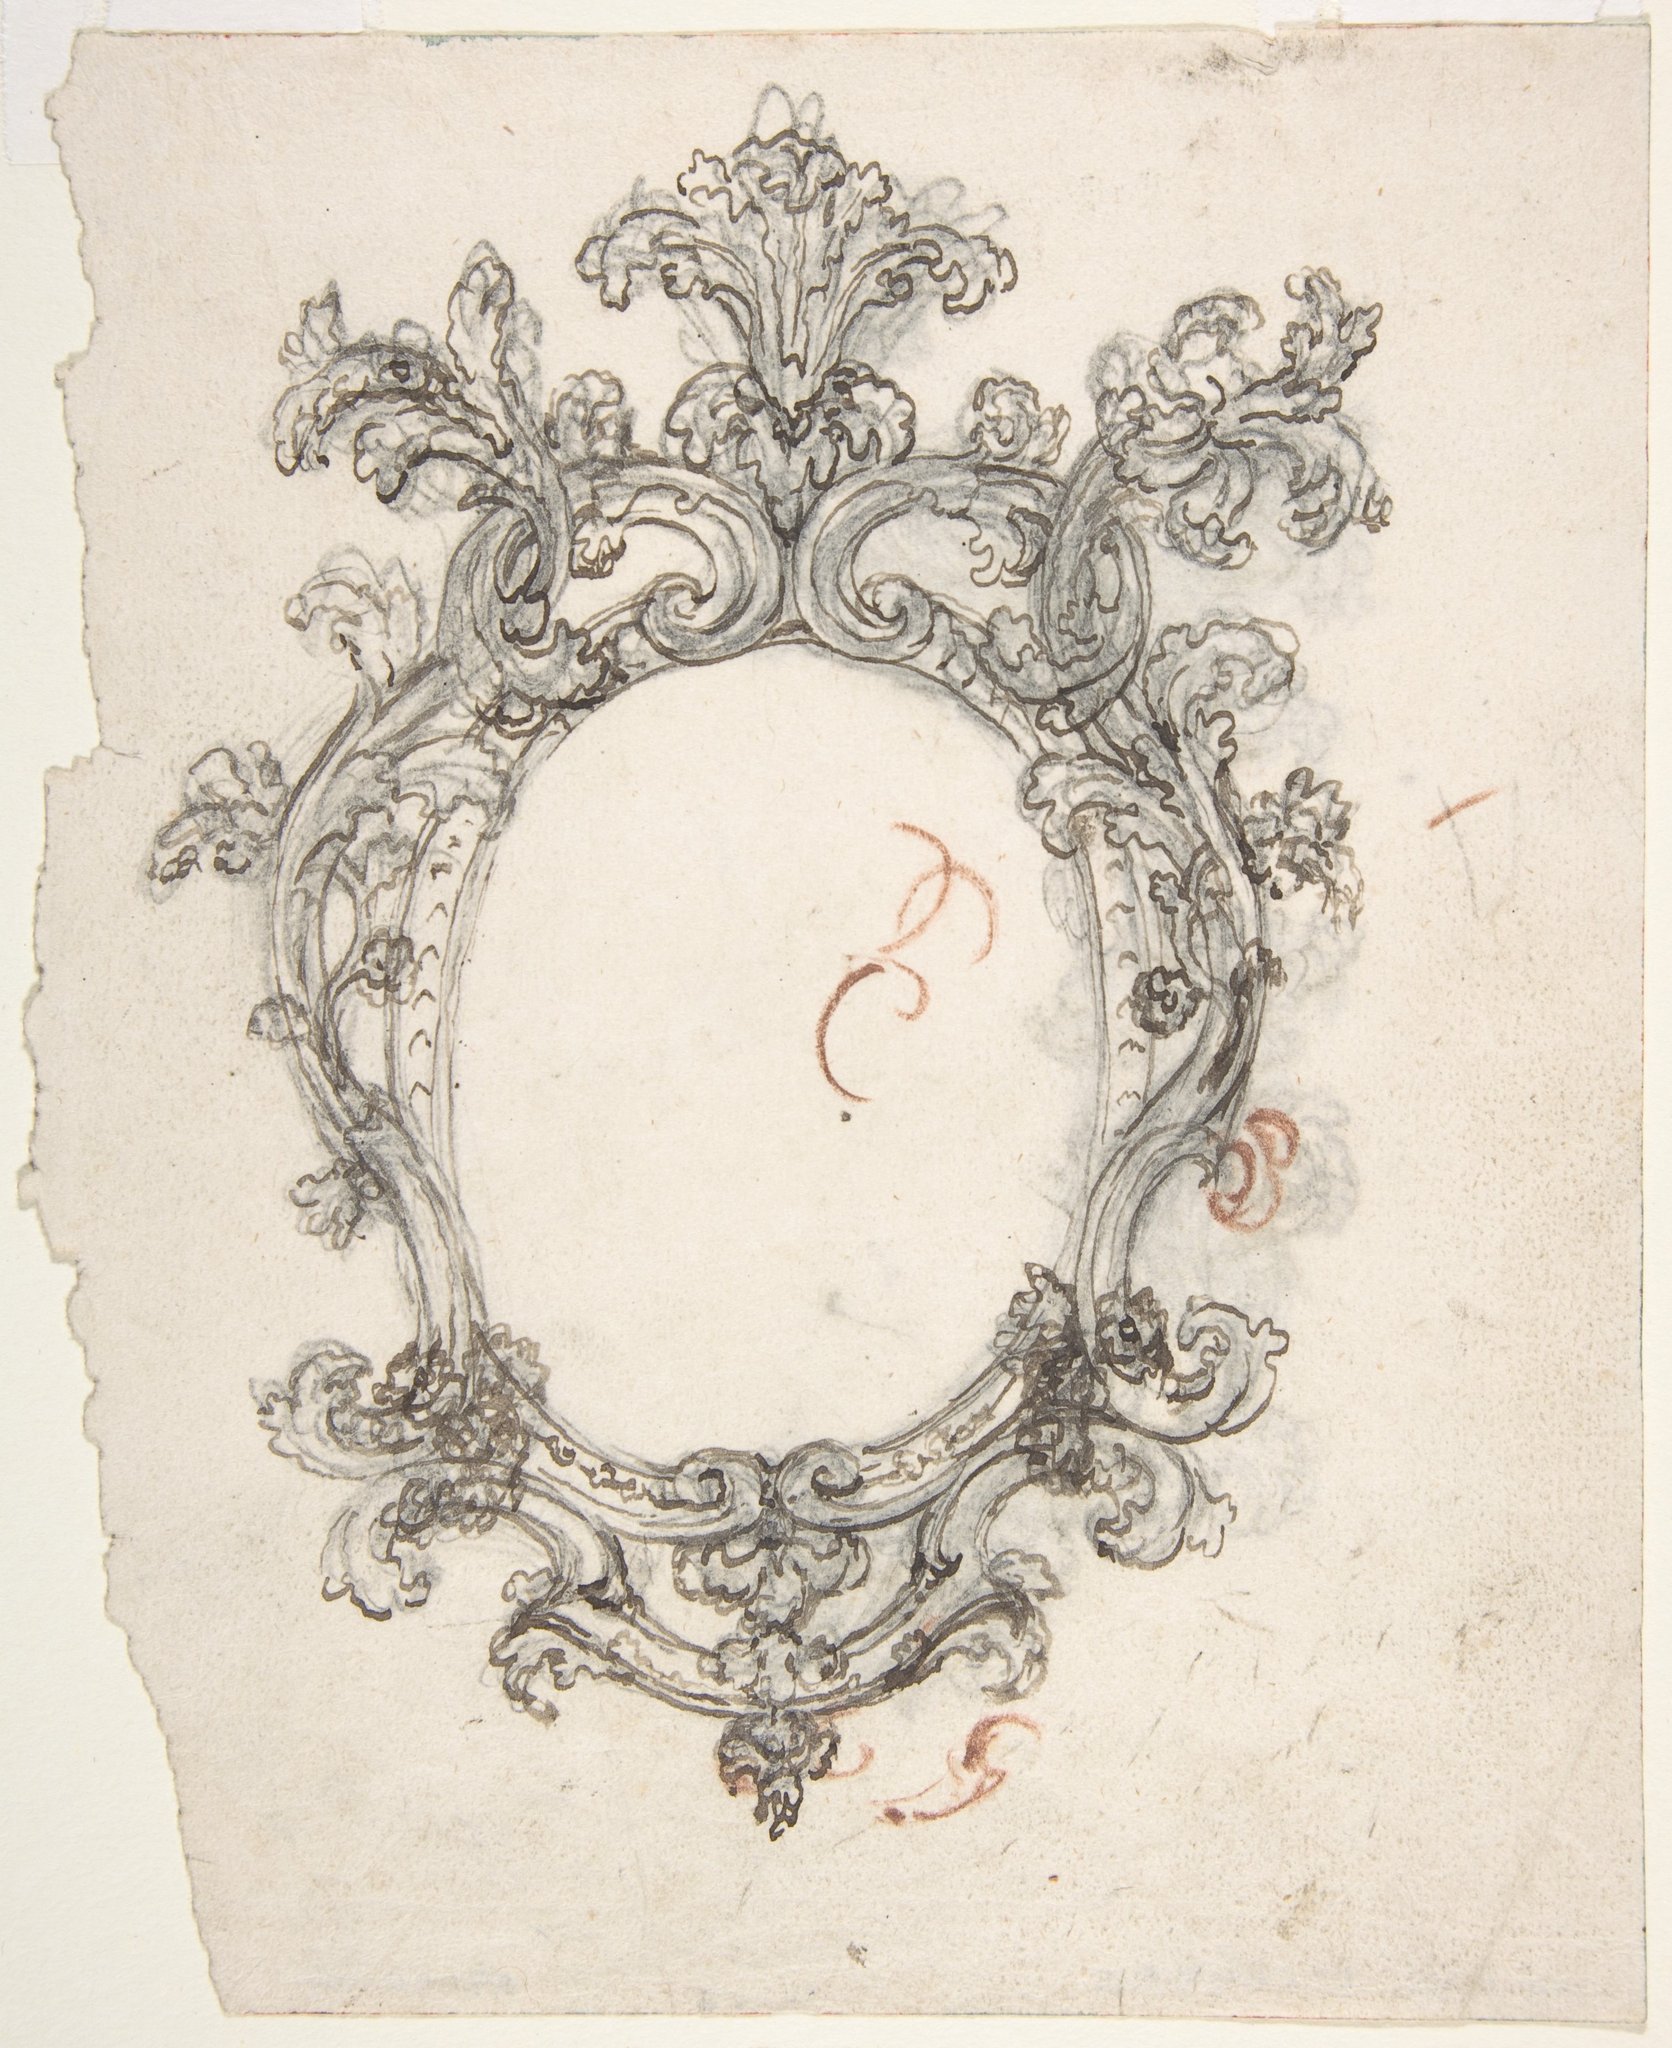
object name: drawing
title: Design for a Decorative Oval Frame (recto); Half sketch for a Decorative Oval Frame (verso)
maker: giovanni battista foggini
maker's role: artist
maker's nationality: italian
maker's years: 1652-1725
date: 1672-1725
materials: chalk, ink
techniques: pen